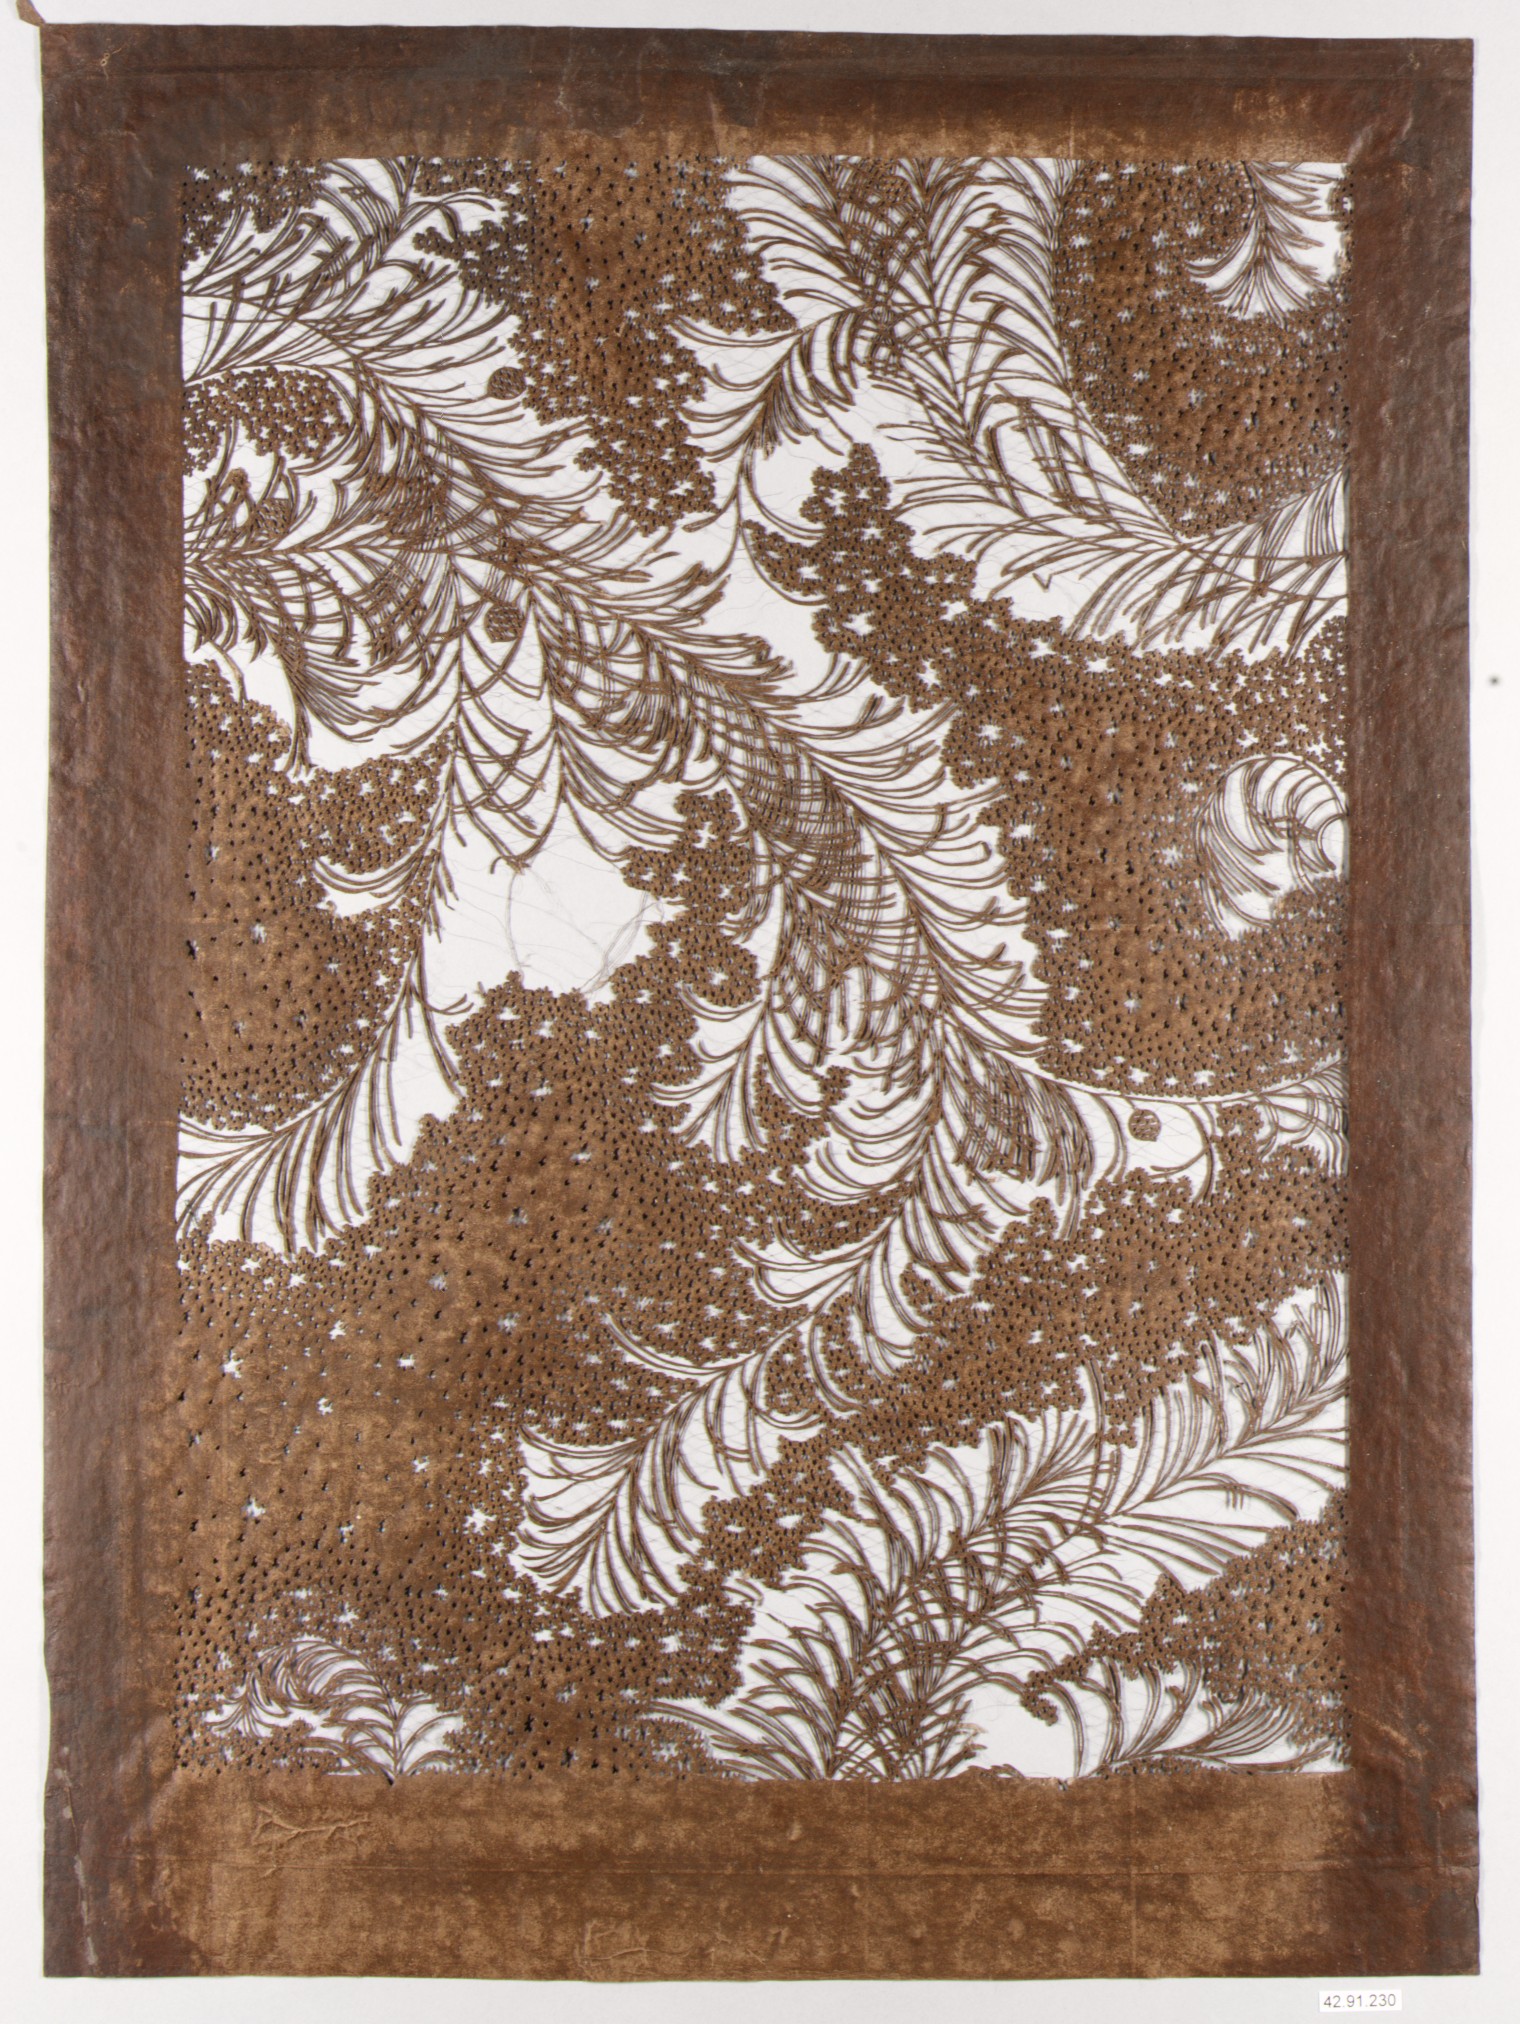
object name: stencil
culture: japanese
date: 1801-1900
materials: paper, silk